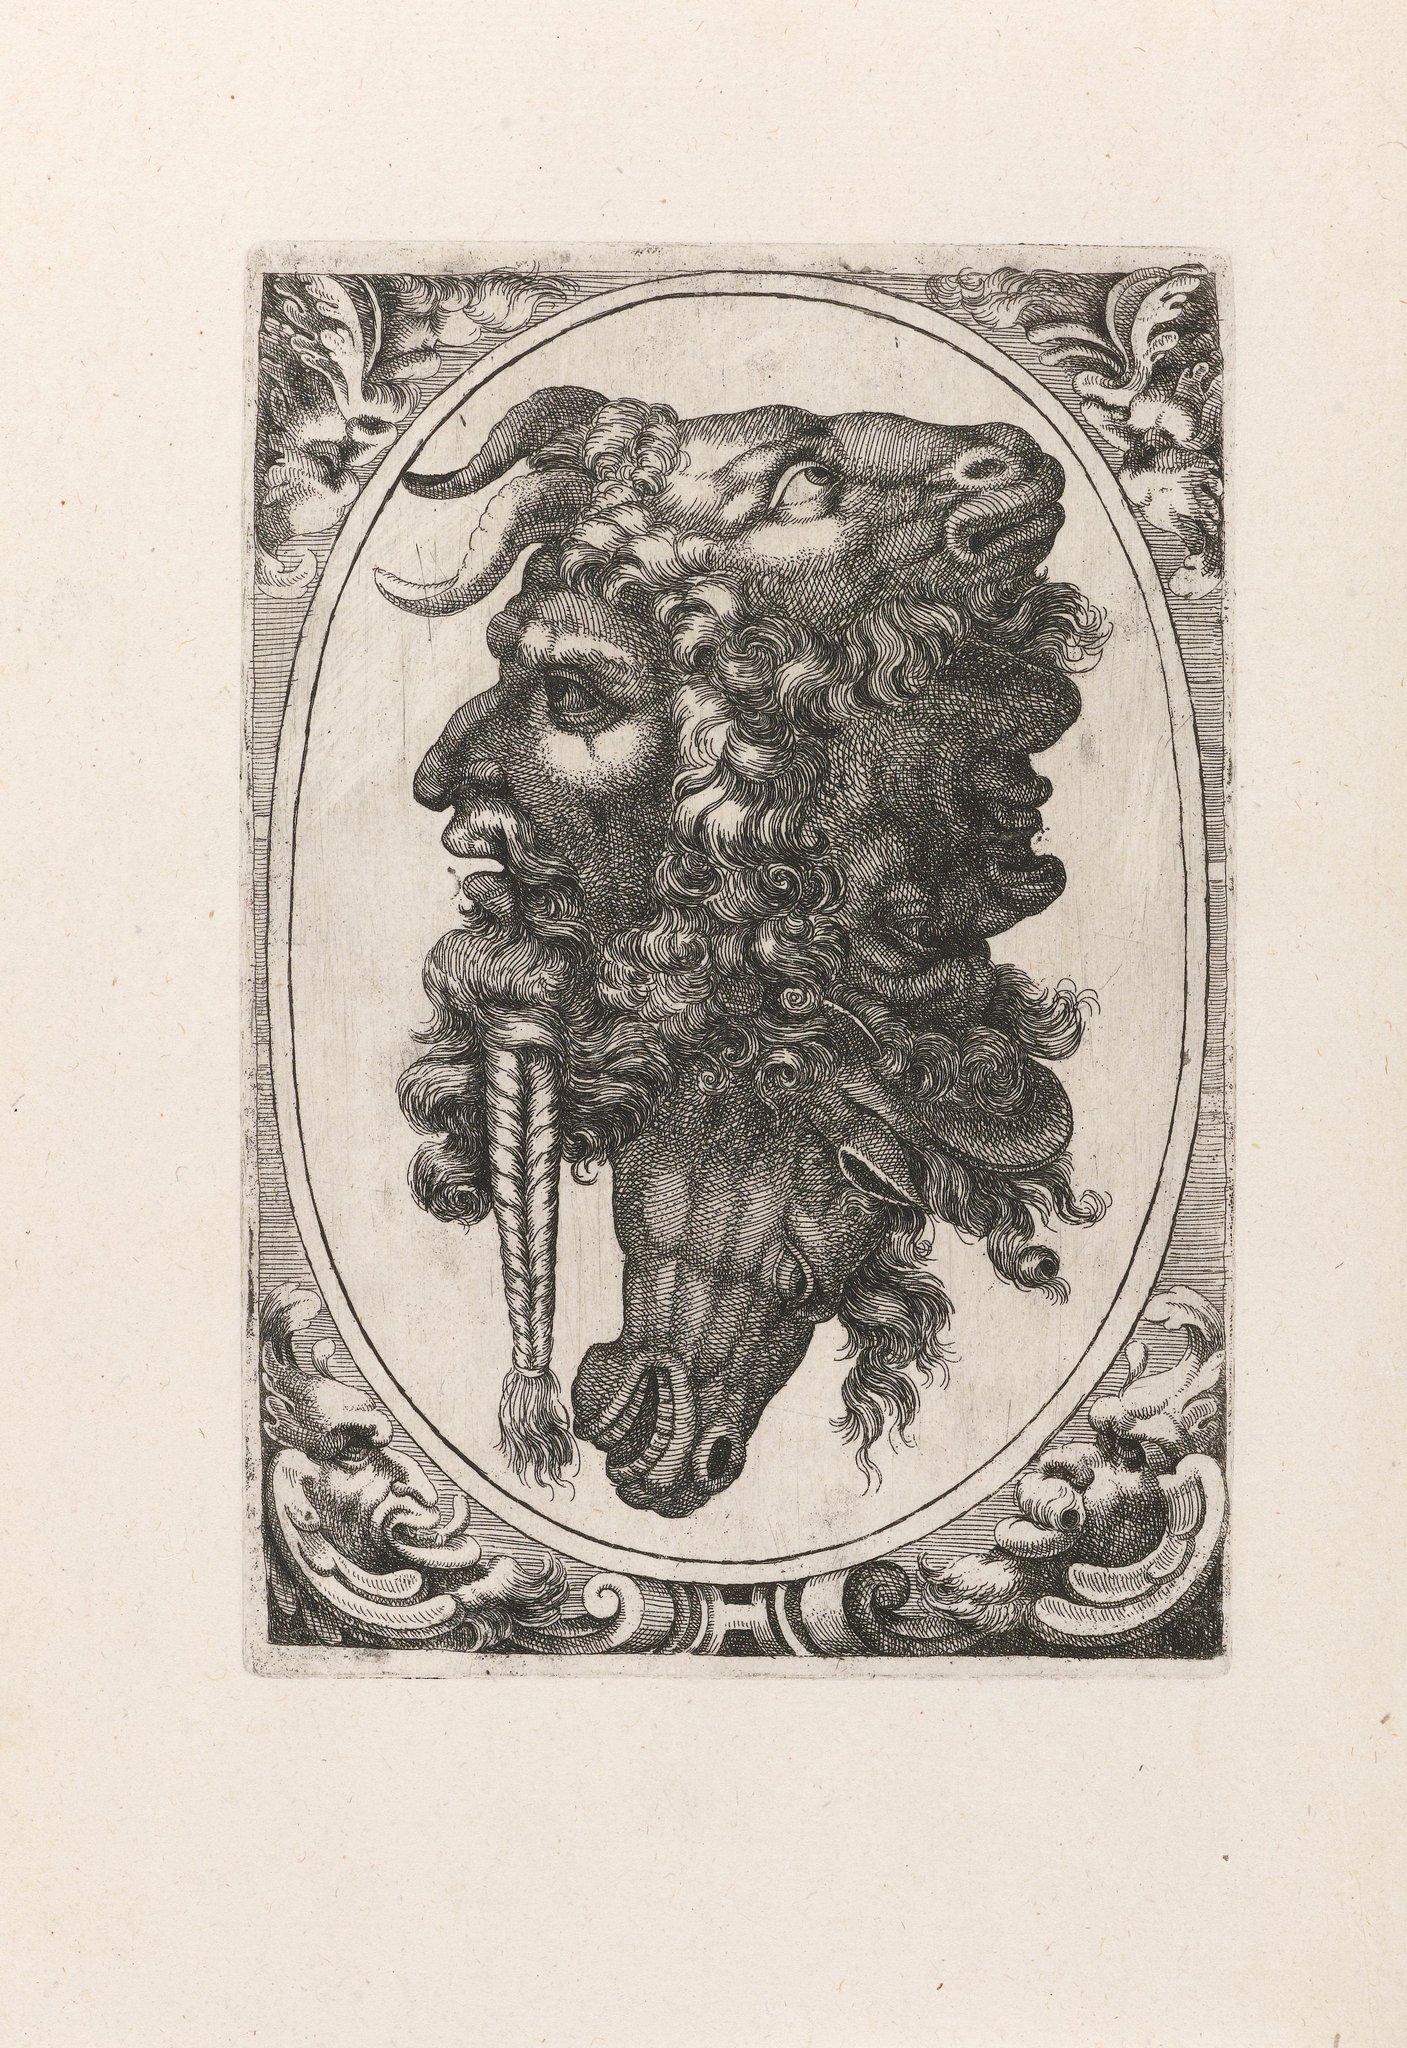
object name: ornament print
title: Samengestelling van twee gezichten, een paardenkop en een geitenkop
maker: giovanni andrea maglioli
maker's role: designer, print maker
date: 1580-1610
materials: paper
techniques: etching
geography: italy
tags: anthropomorphic ornament, mask, mascaron ~ ornament, horse, goat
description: Samenstelling van twee gezichten van mannen, de kop van een geit en de kop van een paard. De baardharen van de linker man zijn gevlochten. Gevat in een ovaal met in de vier hoeken ornamentale maskers.